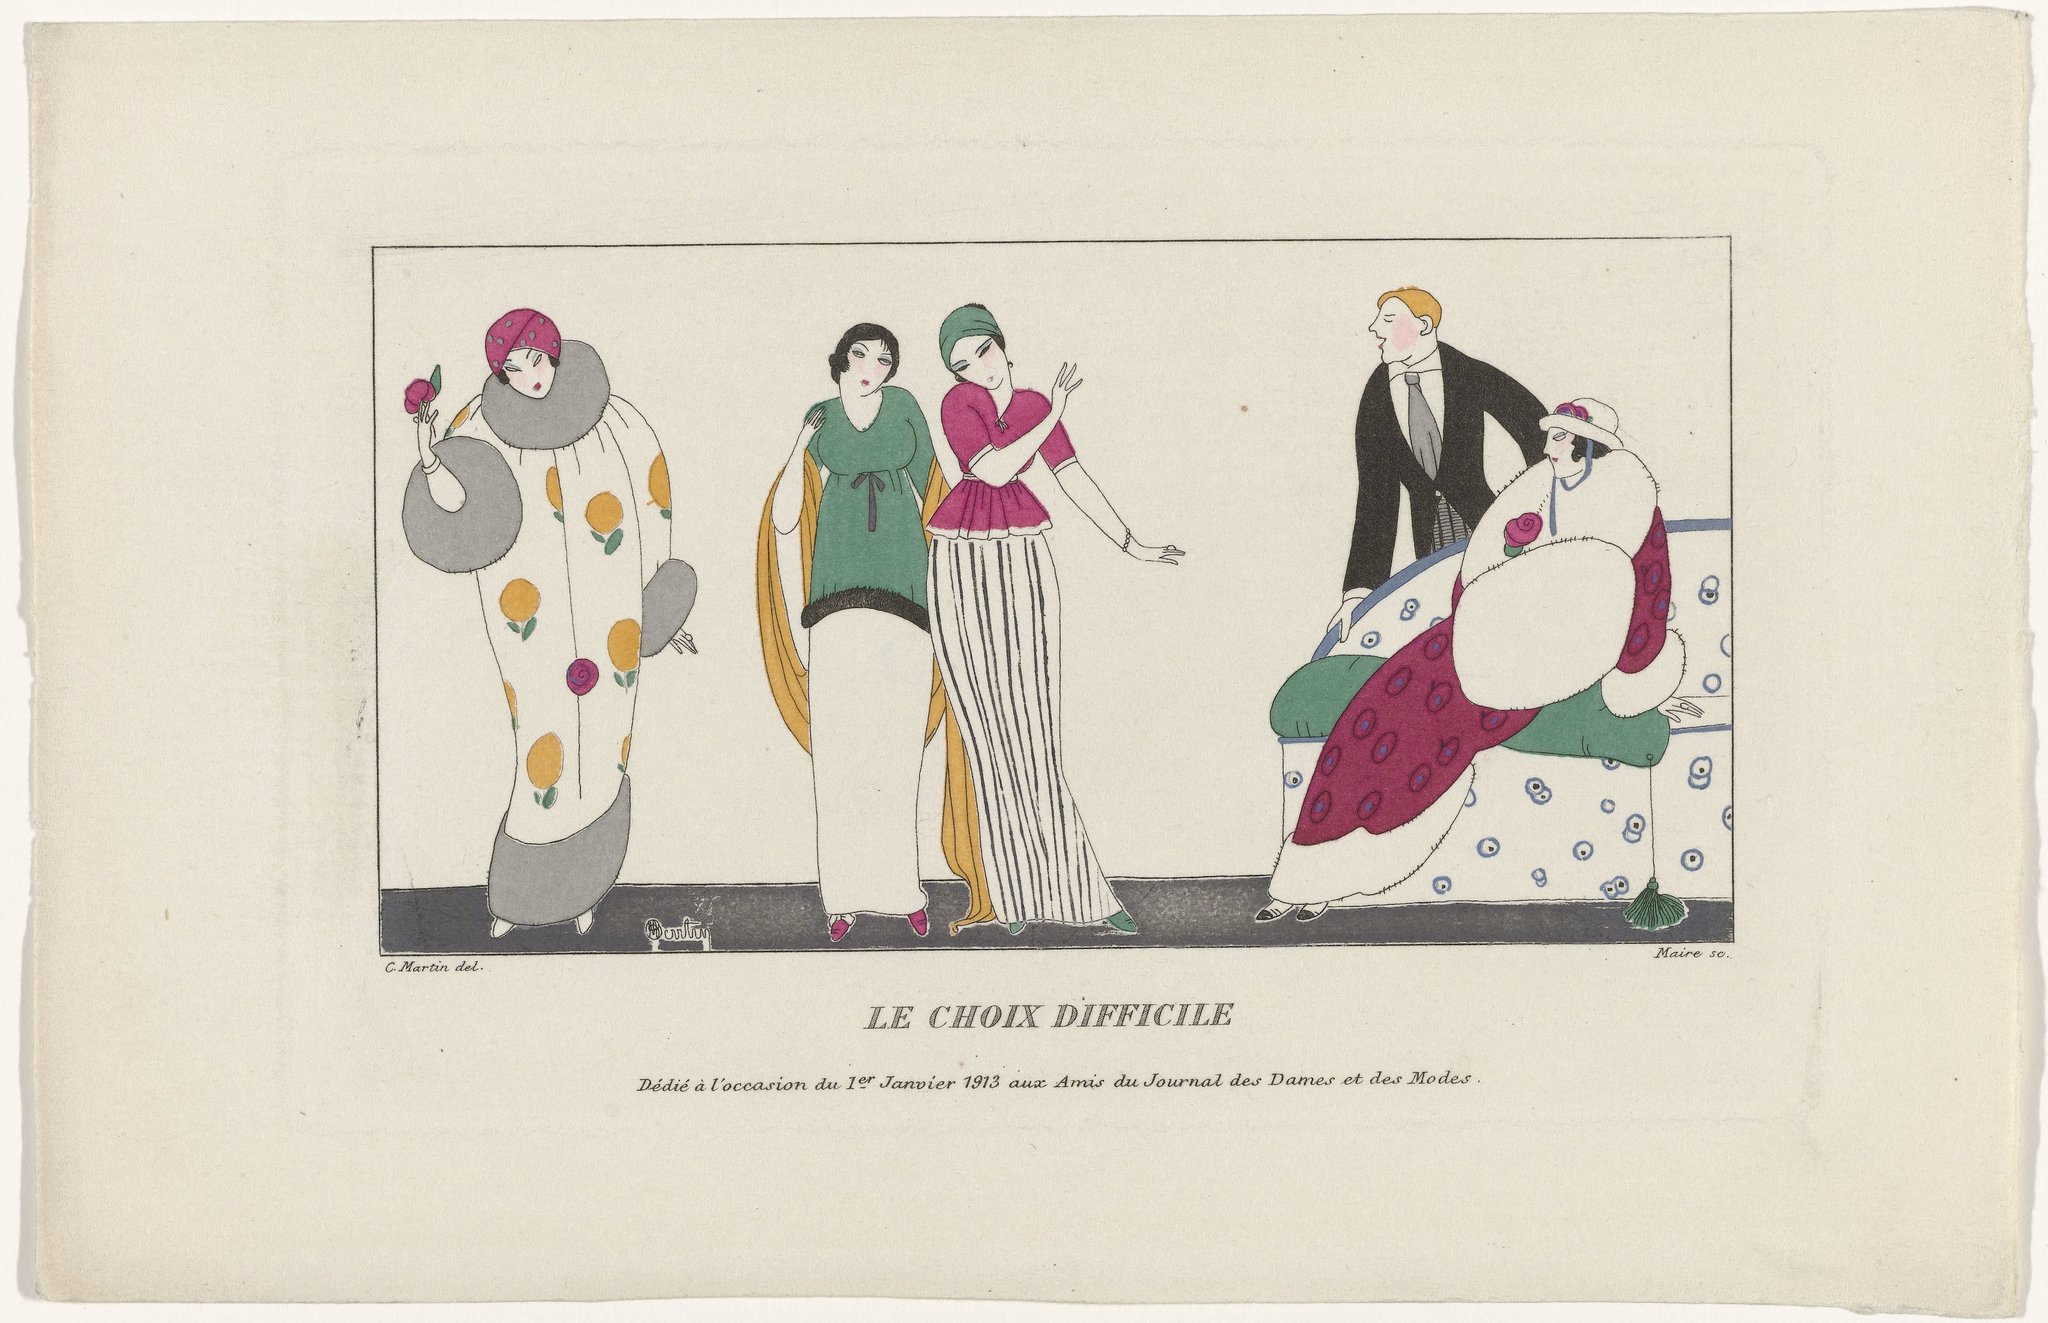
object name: fashion print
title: Journal des Dames et des Modes, 1er Janvier 1913 : Le Choix difficile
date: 1913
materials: paper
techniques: engraving, hand coloring, pochoir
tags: coat (+ women's clothes), head-gear (+ women's clothes), fashion plates, dress, gown (+ women's clothes), model, mannequin, muff (+ women's clothes), customer, merchant, salesman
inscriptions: caption: ‘Dédié à l'occasion du 1er janvier 1913 aux Amis du Journal des Dames et des Modes’, title: ‘Le choix difficile’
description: Drie mannequins tonen kleding aan een klant en verkoper. Volgens het onderschrift is het voor de klant een moeilijke keuze. Prent uit het modetijdschrift Journal des Dames et des Modes (1912-1914). Prent uit het modetijdschrift Journal des Dames et des Modes (1912-1914).